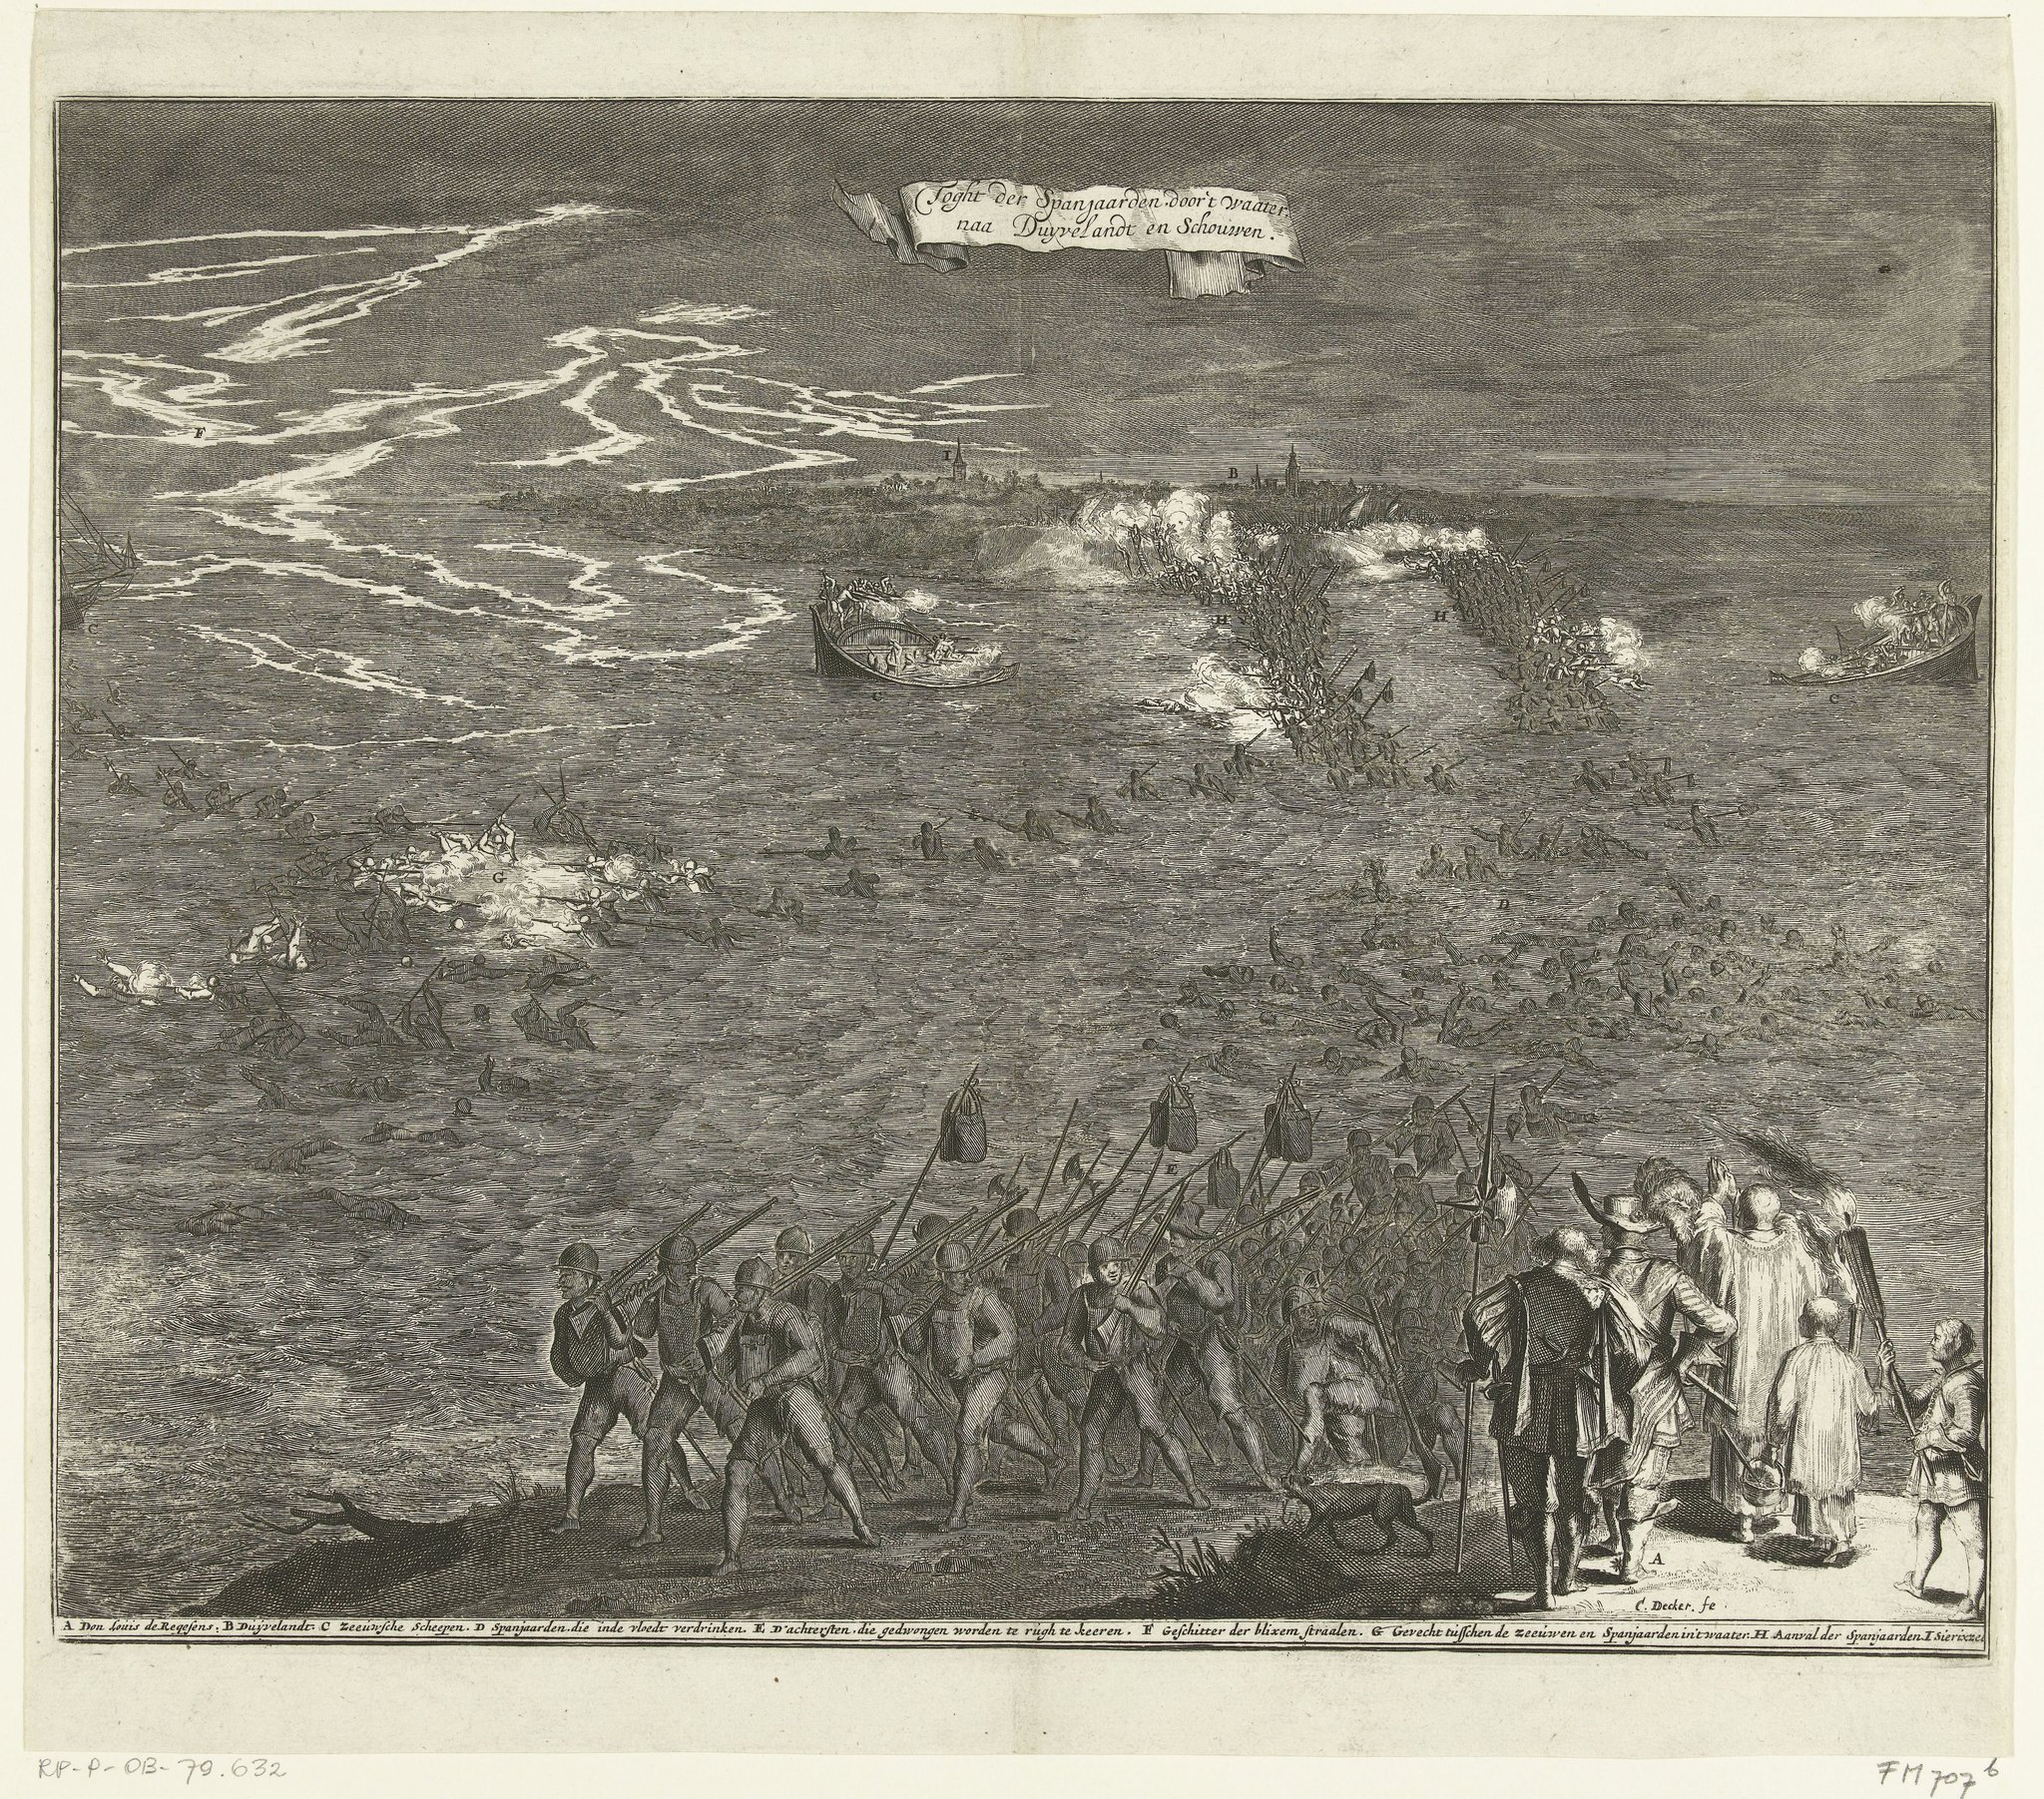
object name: history print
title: Nachtelijk tocht van Spaanse soldaten door het water naar Duiveland, 1575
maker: coenraet decker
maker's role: print maker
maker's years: 1650-1685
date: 1701-1703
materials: paper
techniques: engraving, etching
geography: northern netherlands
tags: brussels, mayor, luis de zúñiga y requesens, army 'en route'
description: Nachtelijk tocht van Spaanse soldaten van Sint-Philipsland door het water naar het eiland Duiveland, 28 september 1575. Op de voorgrond op Tholen zegent een jezuïet de vertrekkende soldaten, in de verte het eiland Duivenland en Zierikzee. Onderaan de legenda A-I in het Nederlands.